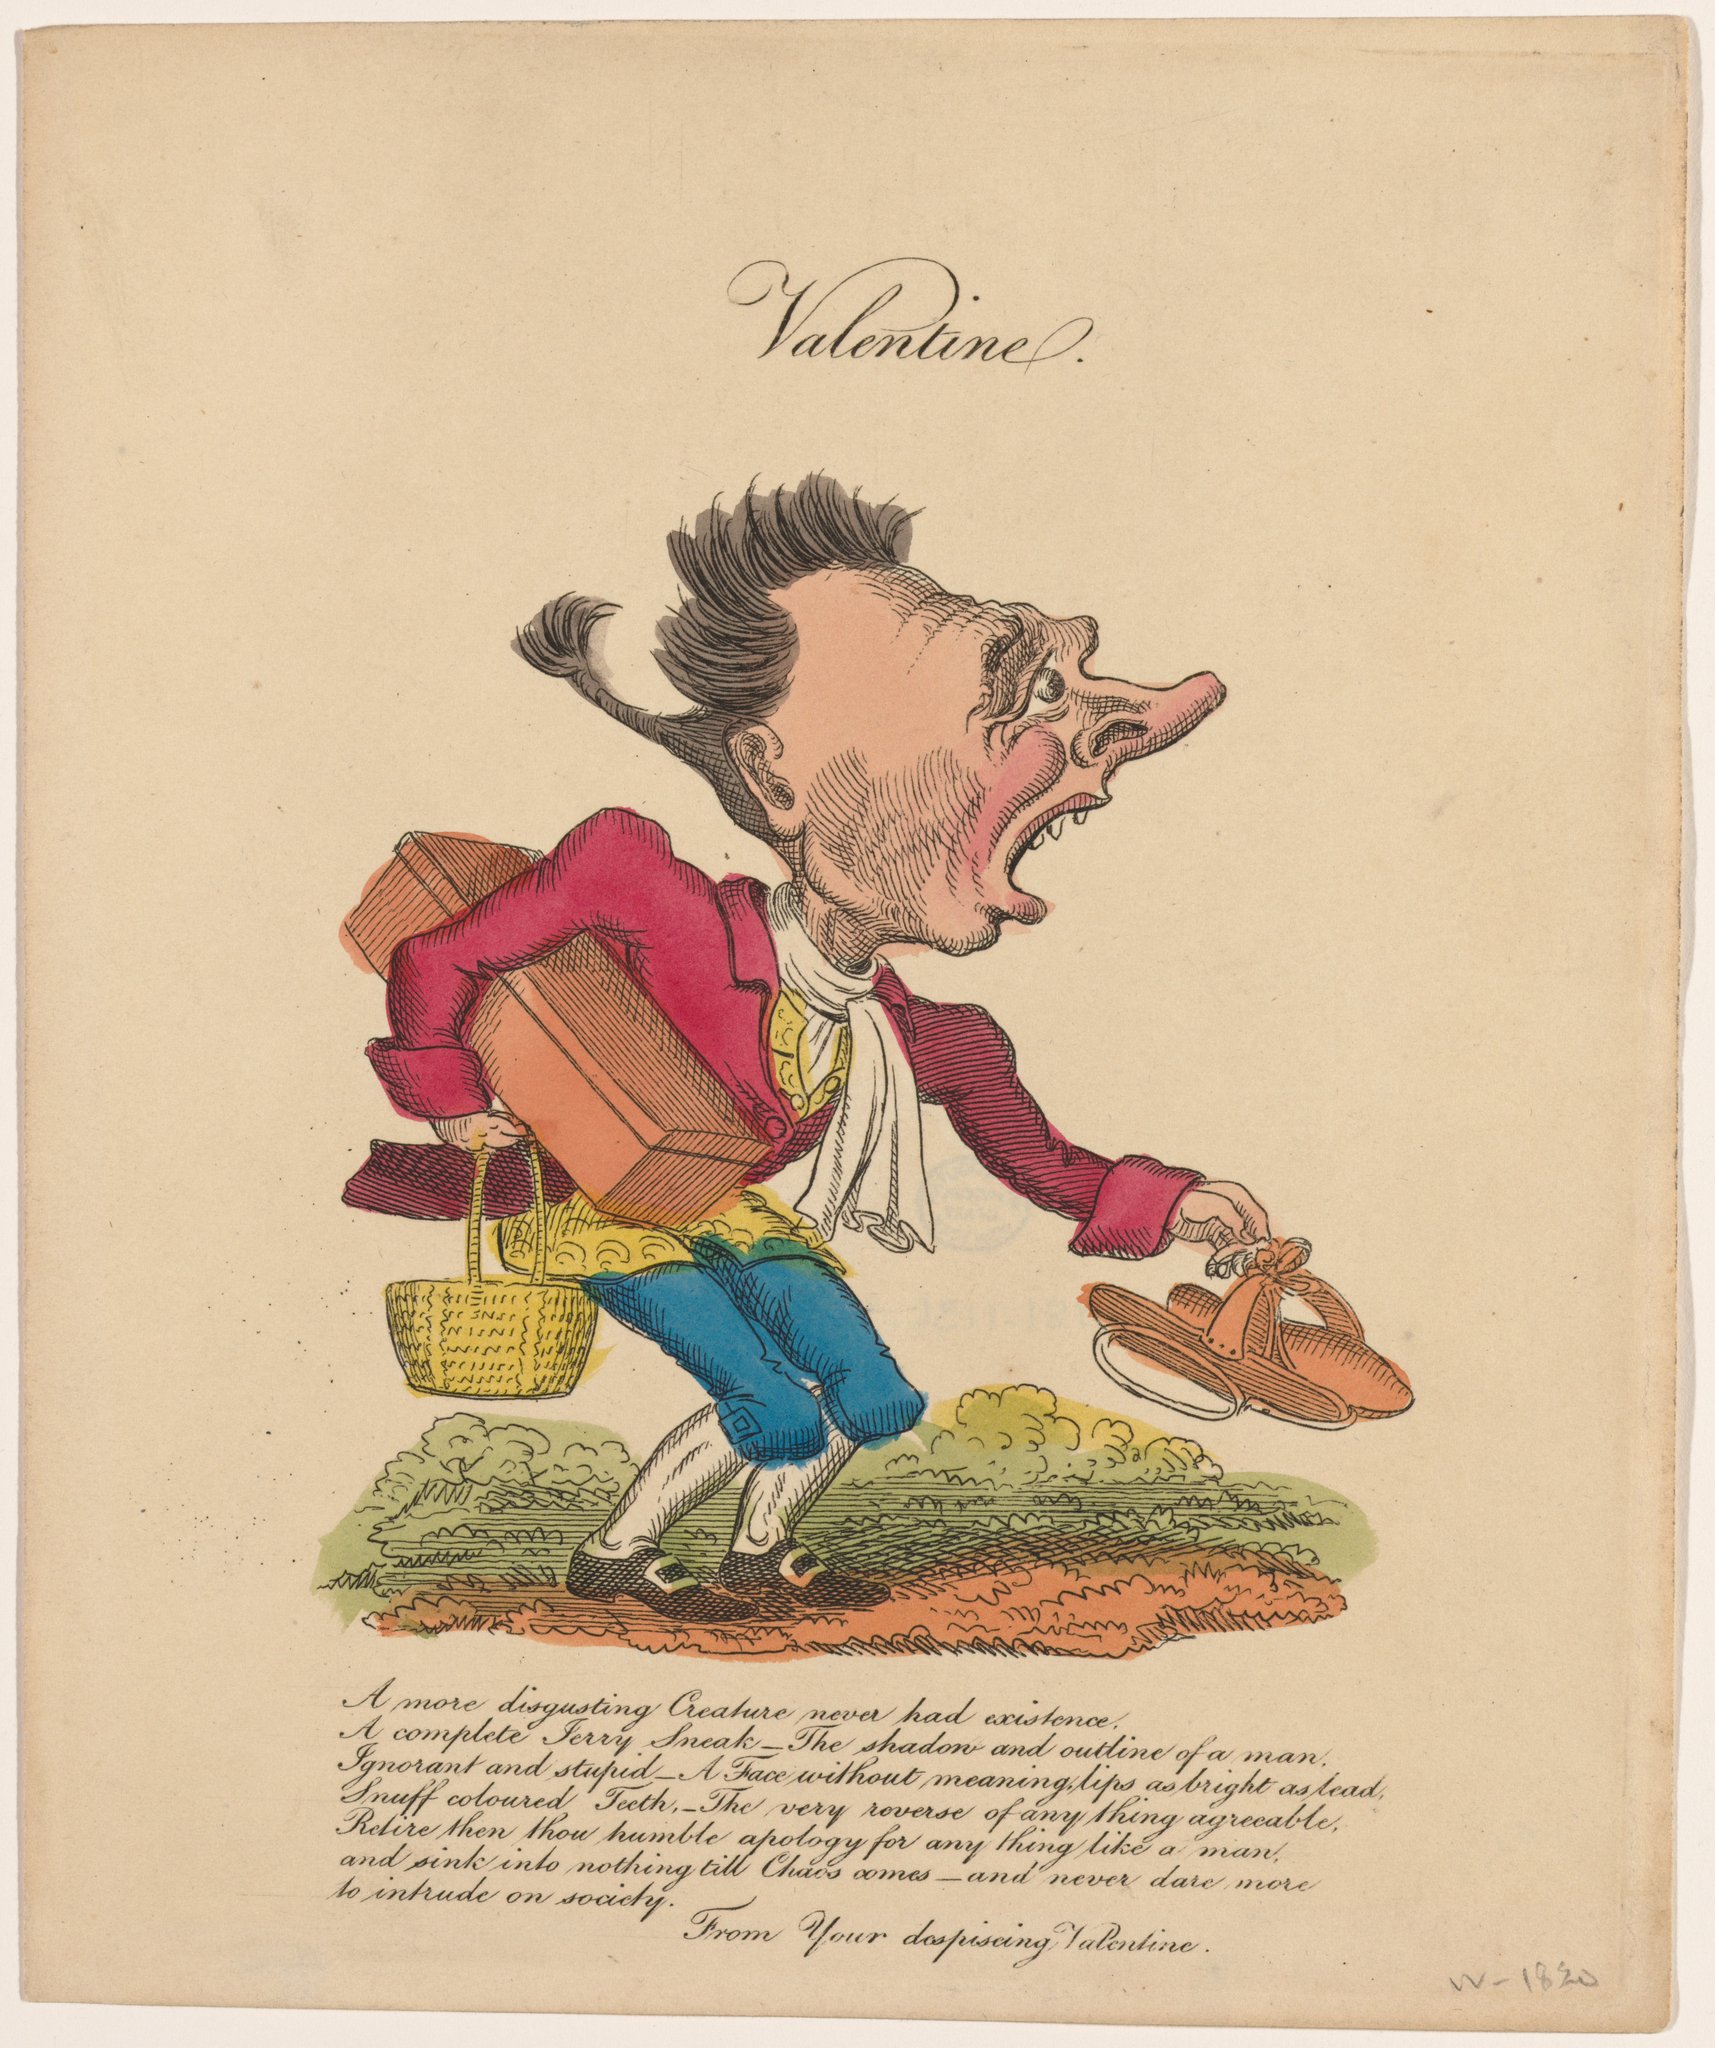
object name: valentine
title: Comic Valentine (Despising Valentine)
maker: Anonymous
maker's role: artist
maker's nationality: british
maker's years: 1800-1899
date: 1820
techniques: engraving, hand coloring